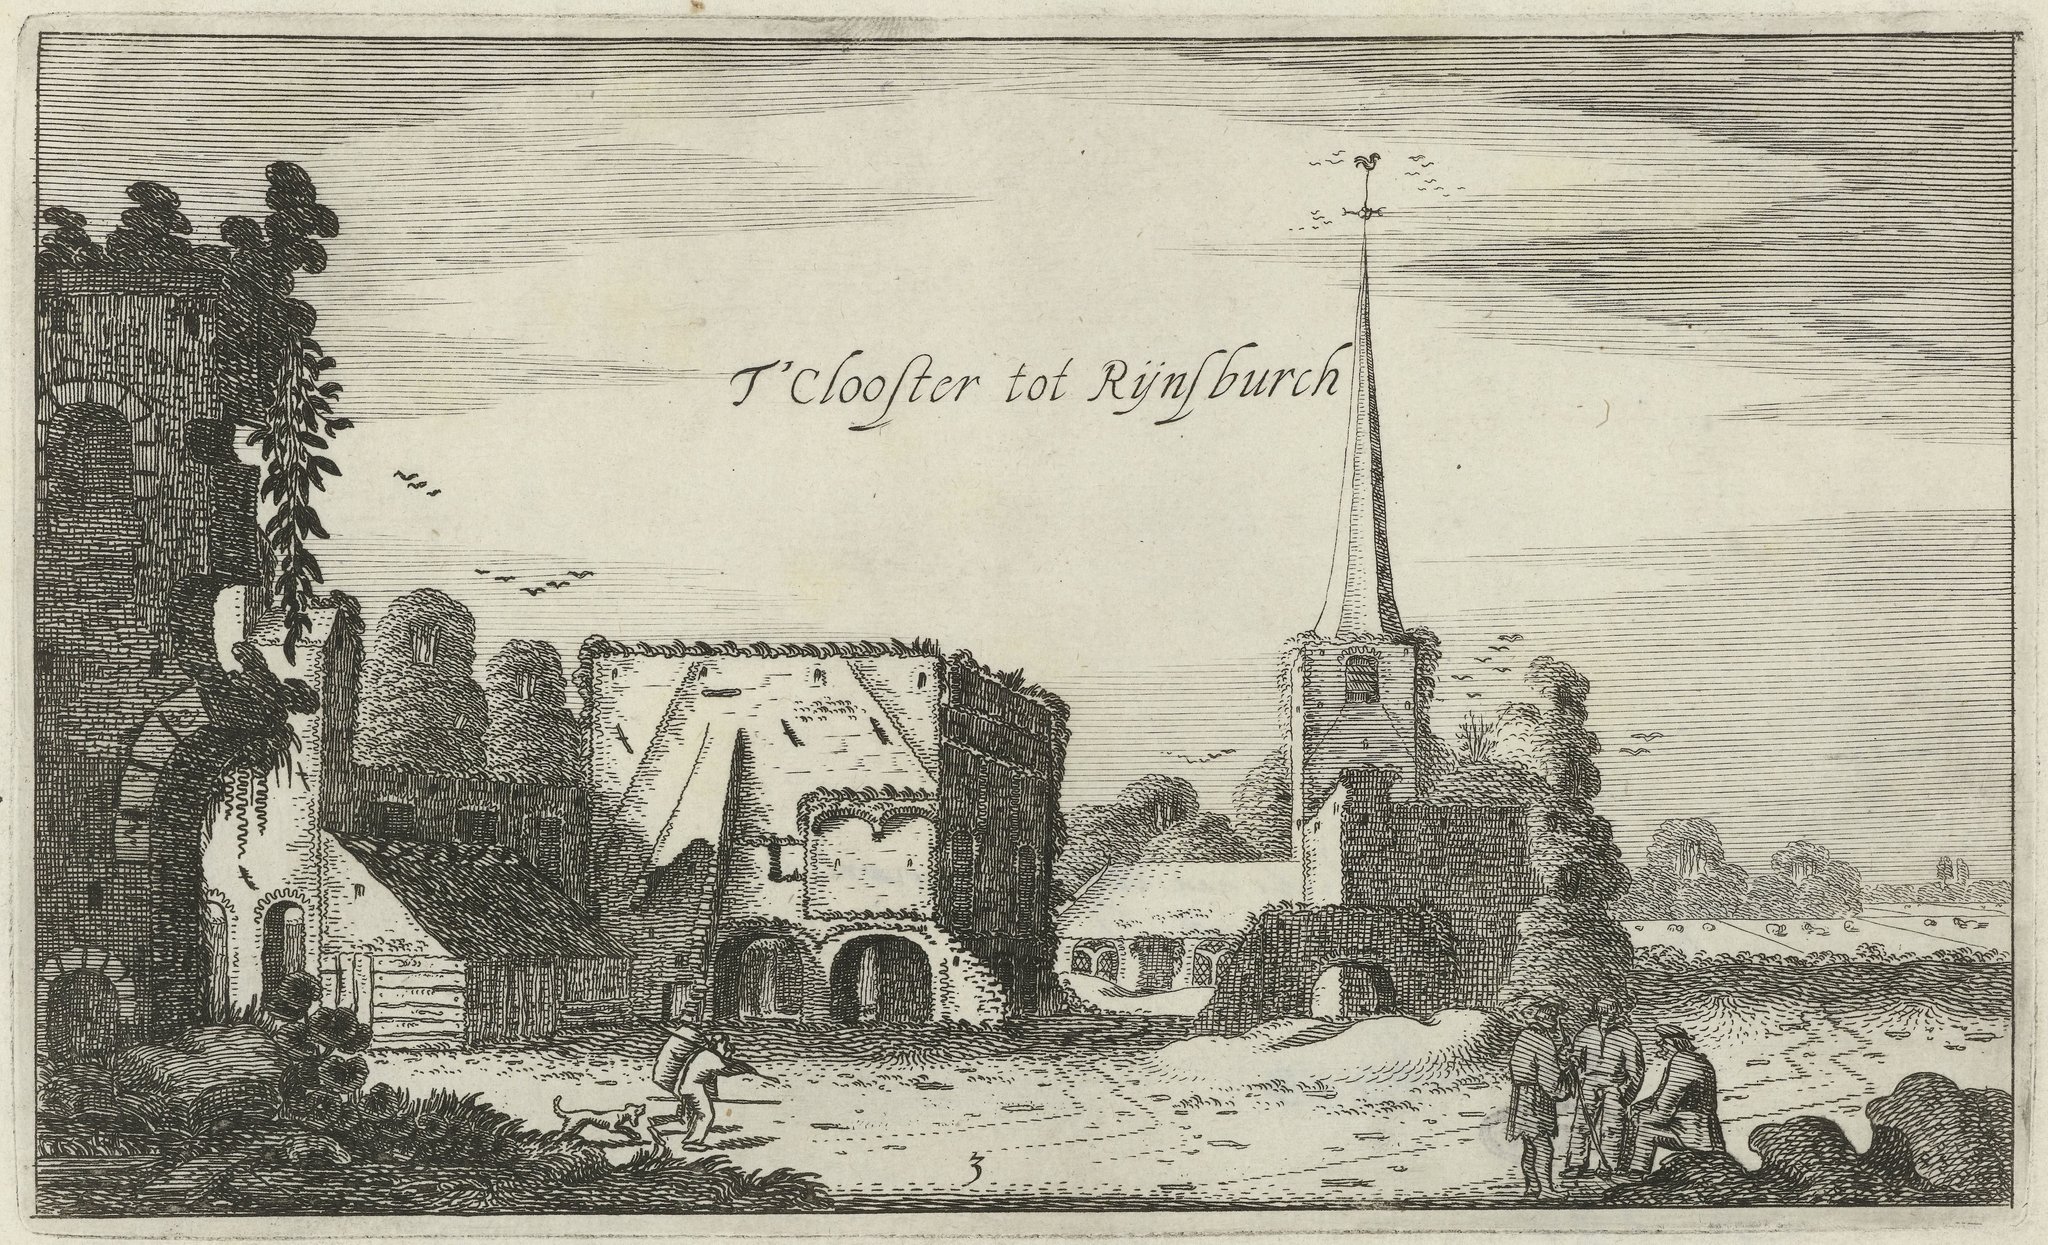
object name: print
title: Kastelen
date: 1616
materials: paper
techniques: etching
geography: northern netherlands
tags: landscape with ruins, landscape with tower or castle, cloisters ~ monastery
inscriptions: collector's mark: Lugt 964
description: Ruïne van de abdij van Rijnsburg, op de voorgrond links een man met een hond en rechts drie converserende figuren. Derde prent uit een serie van zes.